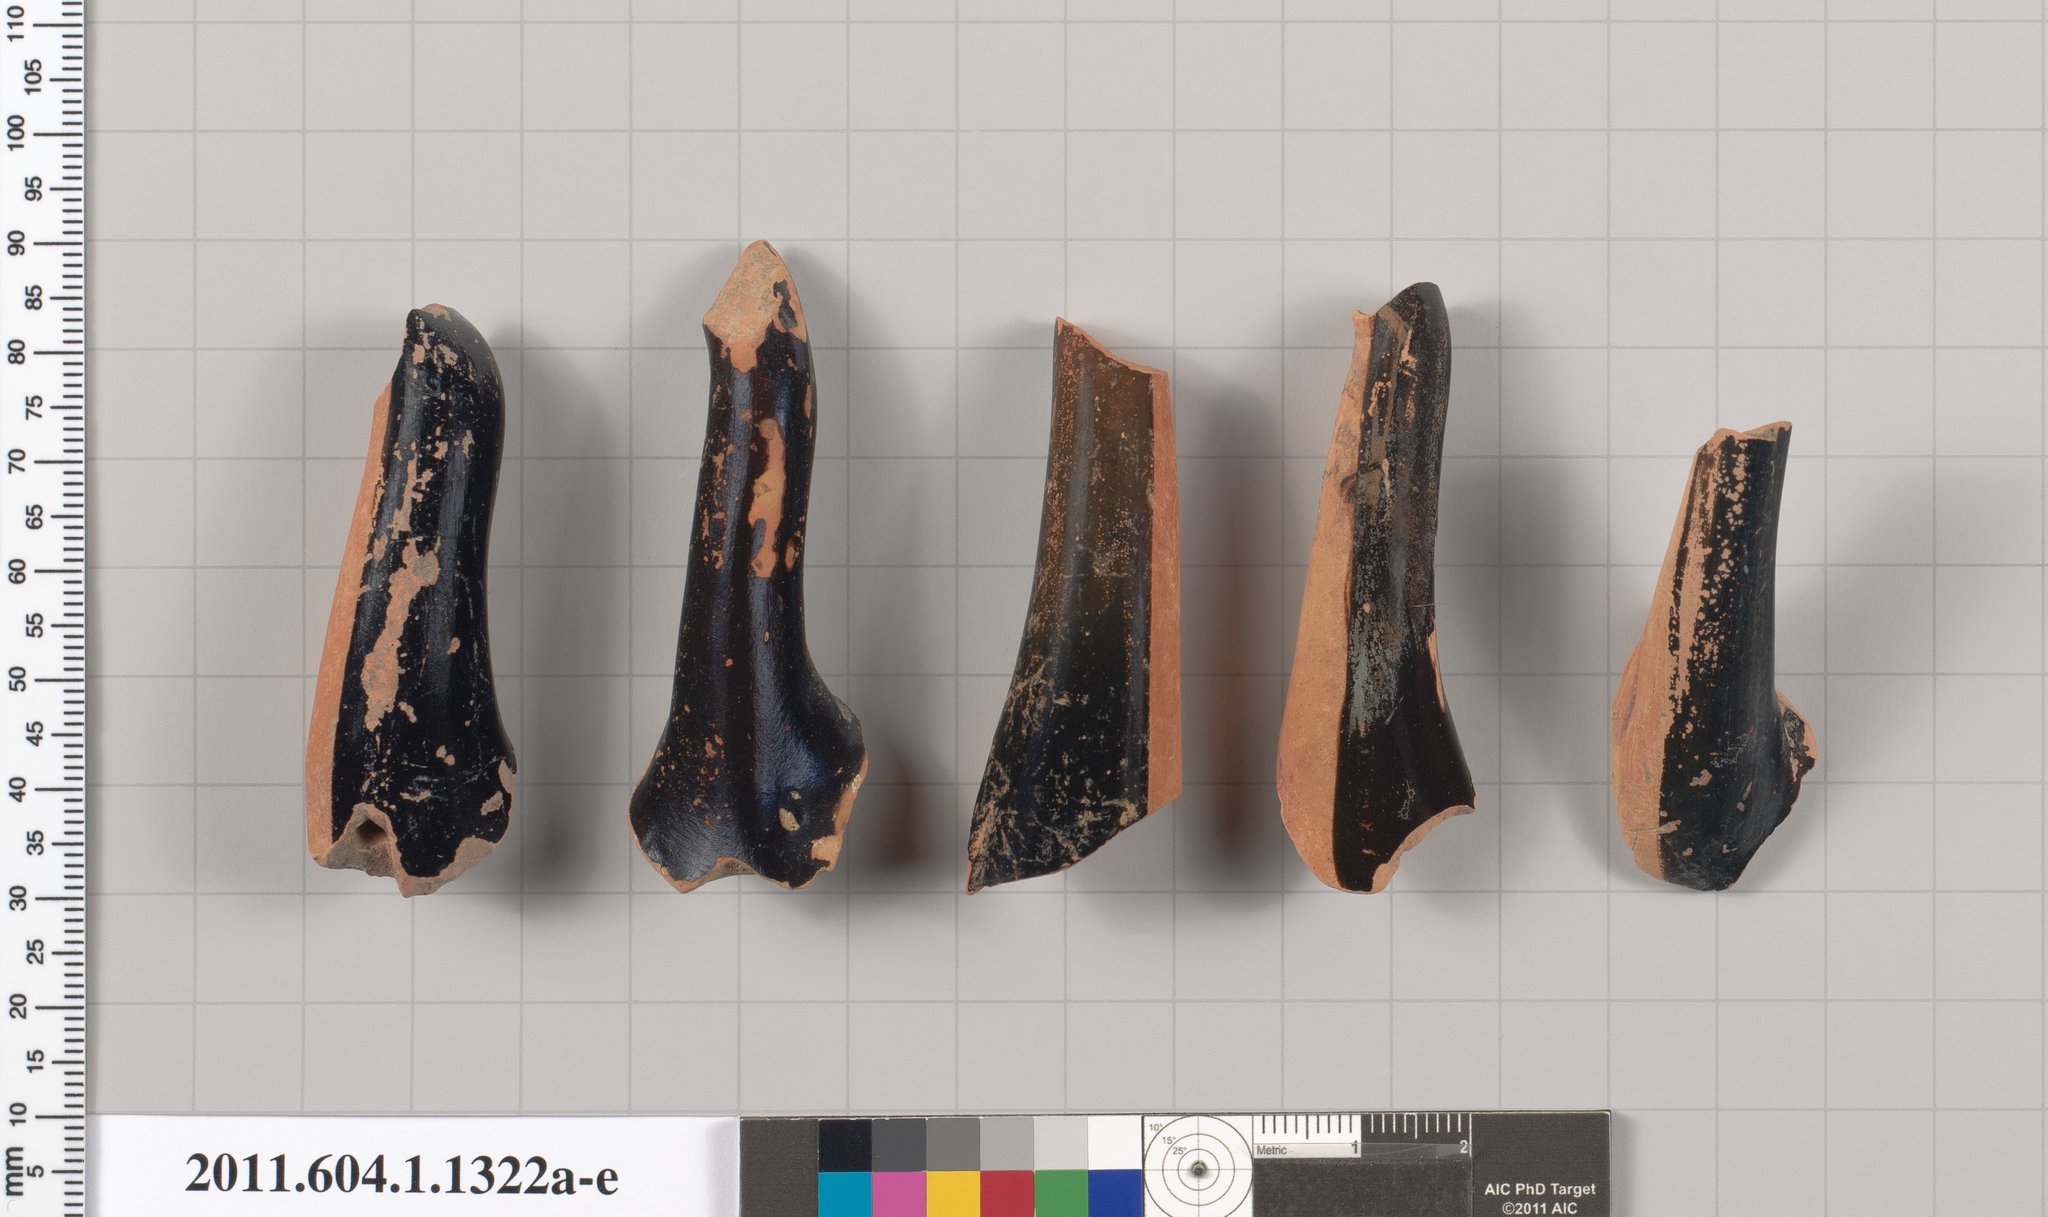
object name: kylix fragment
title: Terracotta fragments of kylikes (drinking cups)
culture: greek, attic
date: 500-401 BCE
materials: terracotta